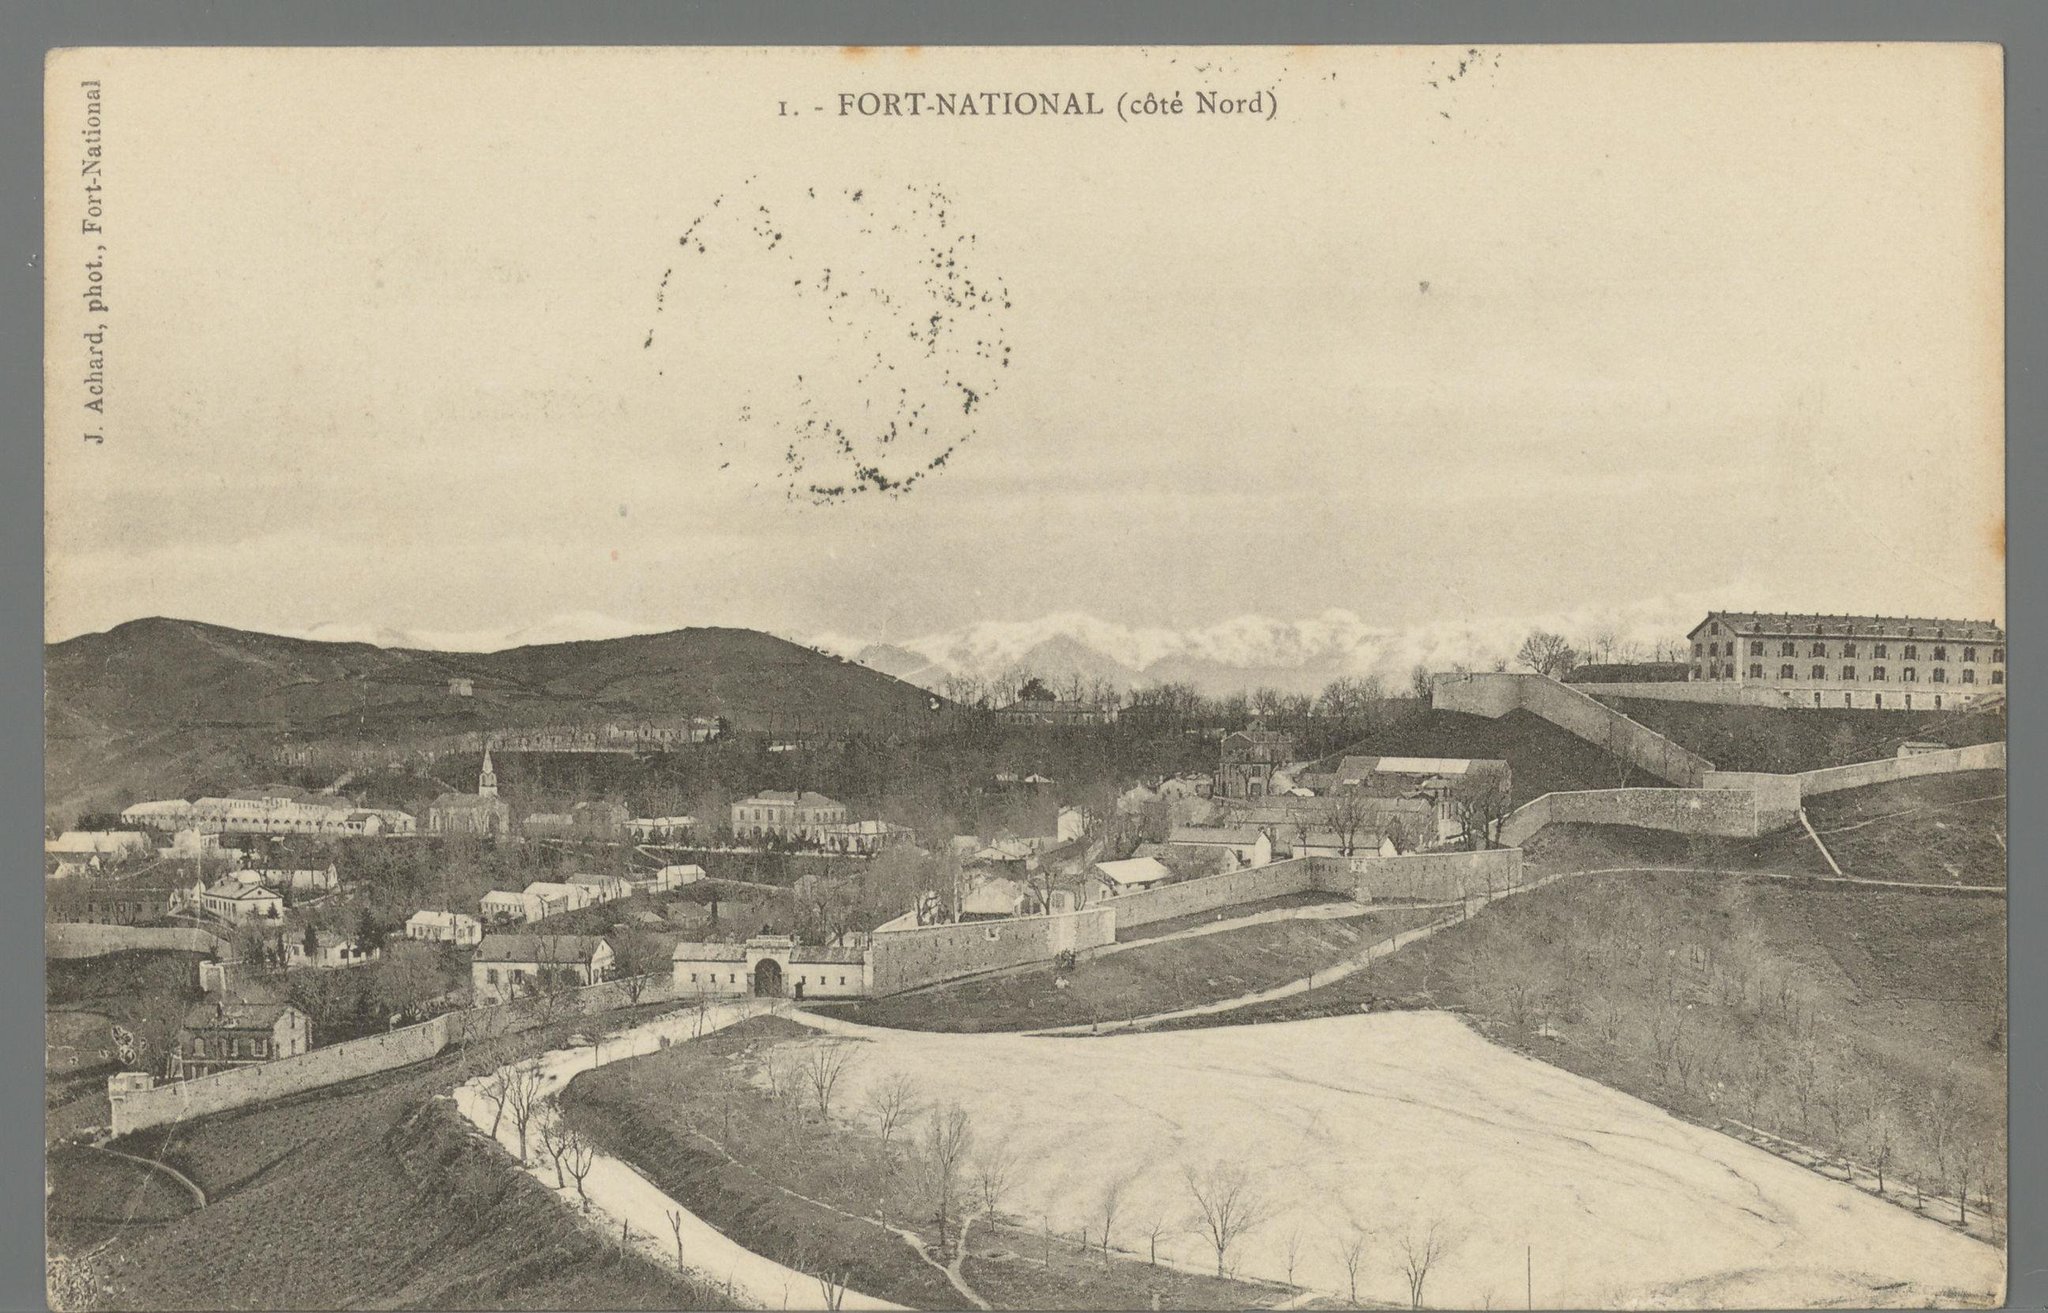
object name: photomechanical print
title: Fort-National (côté Nord)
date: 1903-1904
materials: cardboard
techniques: photograph, writing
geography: fort-national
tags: prospect of village, silhouette of village, mountain-range, snow peaks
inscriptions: postage stamp